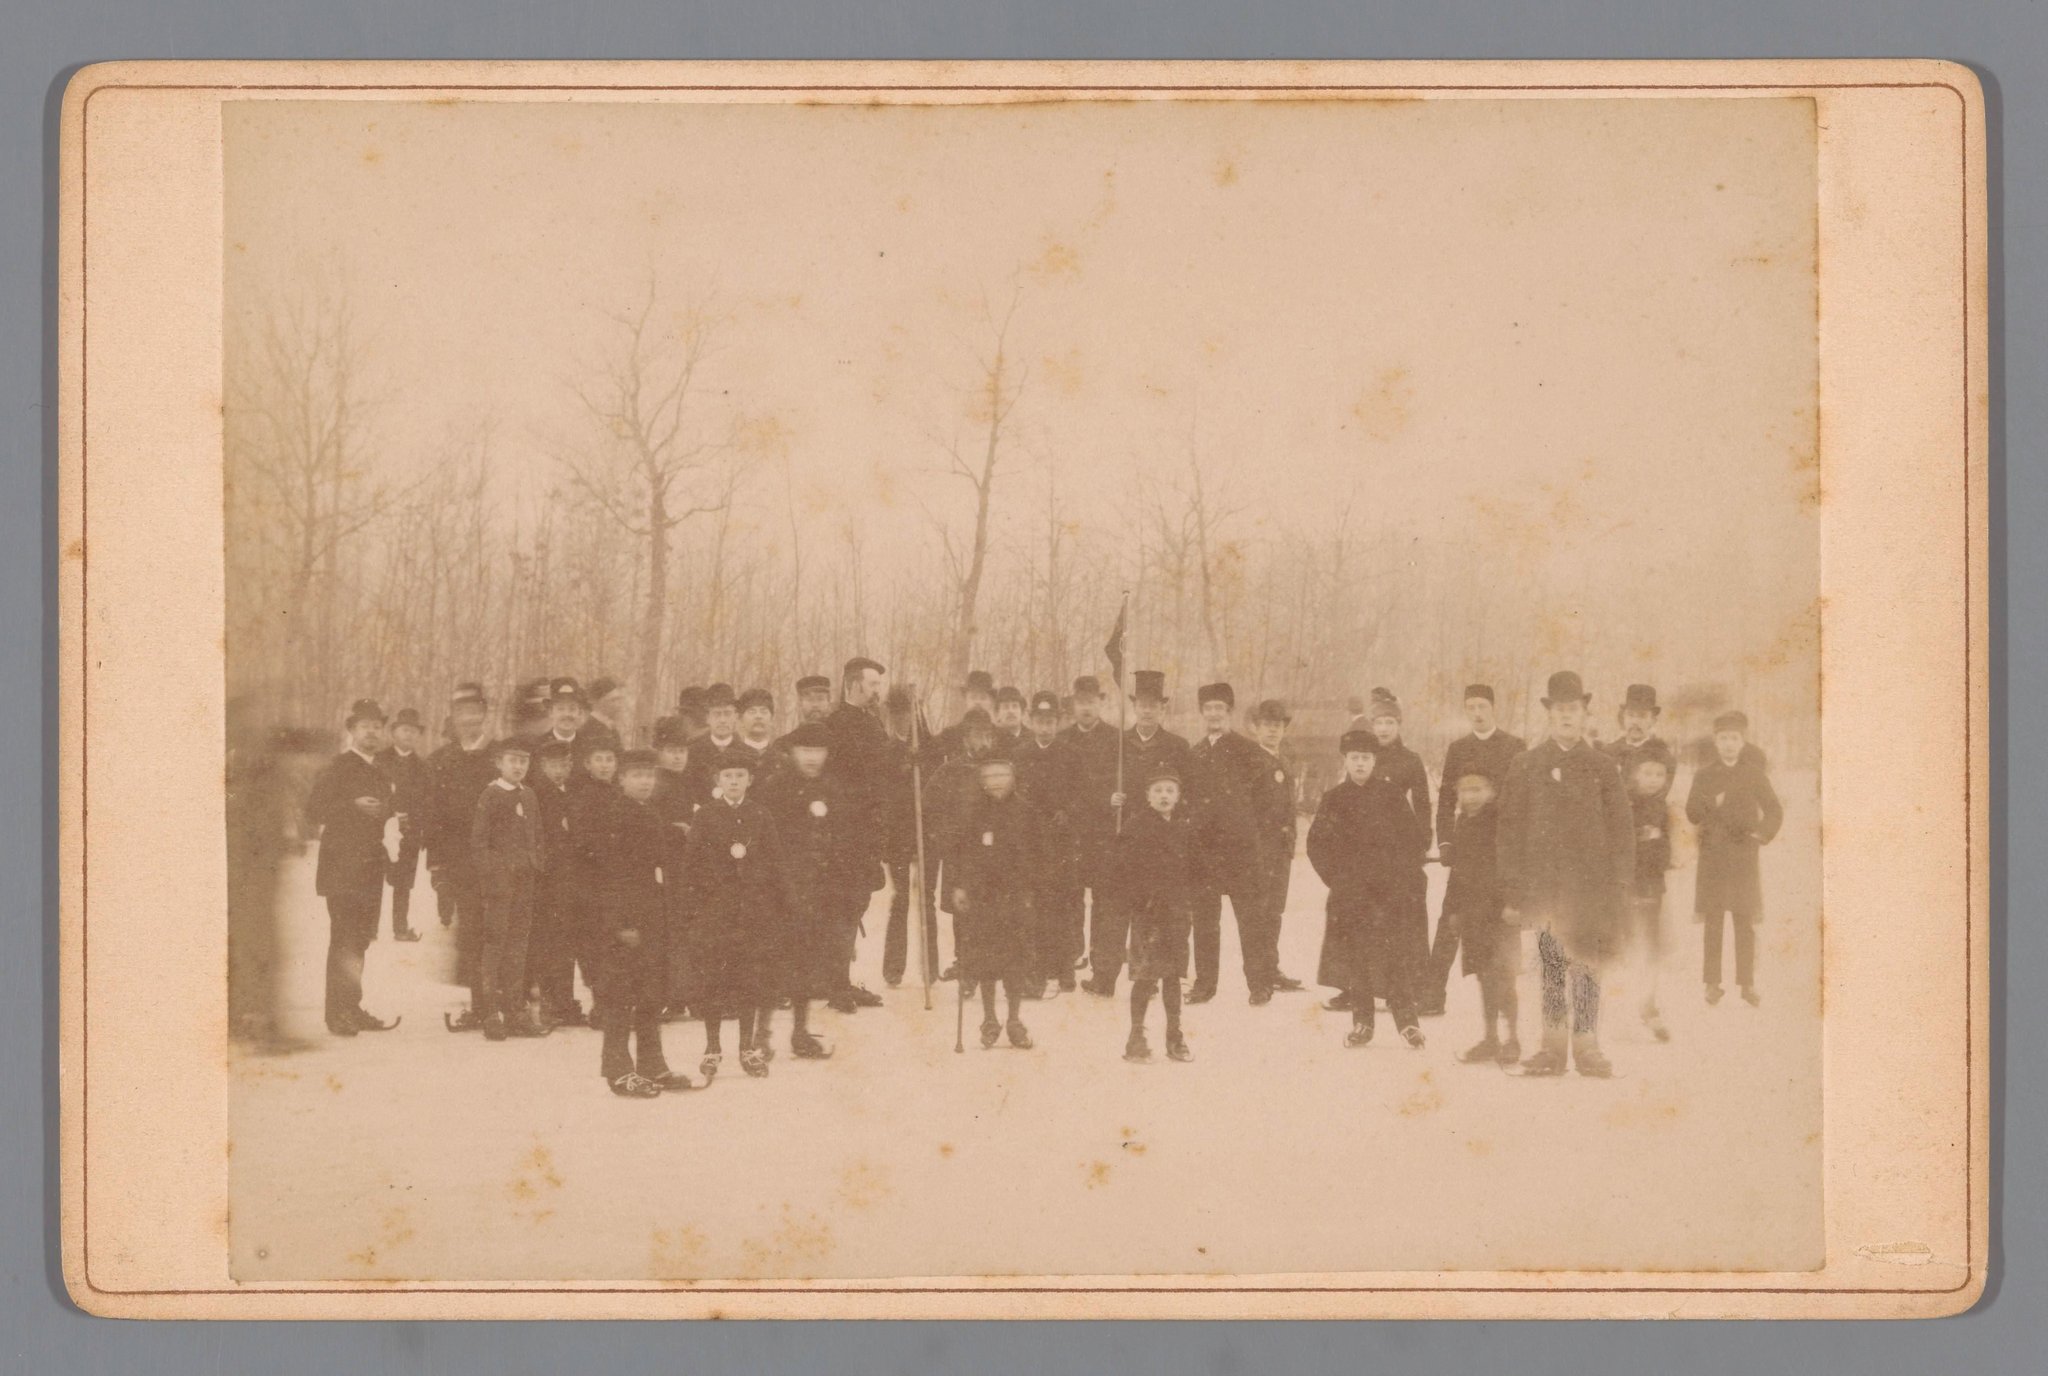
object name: photograph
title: Groep mannen op de baan van de Amsterdamse IJsclub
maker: Anonymous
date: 1887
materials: cardboard, photographic support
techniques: albumen print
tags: adult man (+ more than eight persons), skates (winter sports), amsterdam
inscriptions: annotation: ‘5 Jan 1887/ Souvenier des Baans van den/ Amsterdamschen Ysclub op haar/ ondergepompt land p. 650 meter/ lang & 45 meter breed achter de/ P.C. Hooftstraat.’